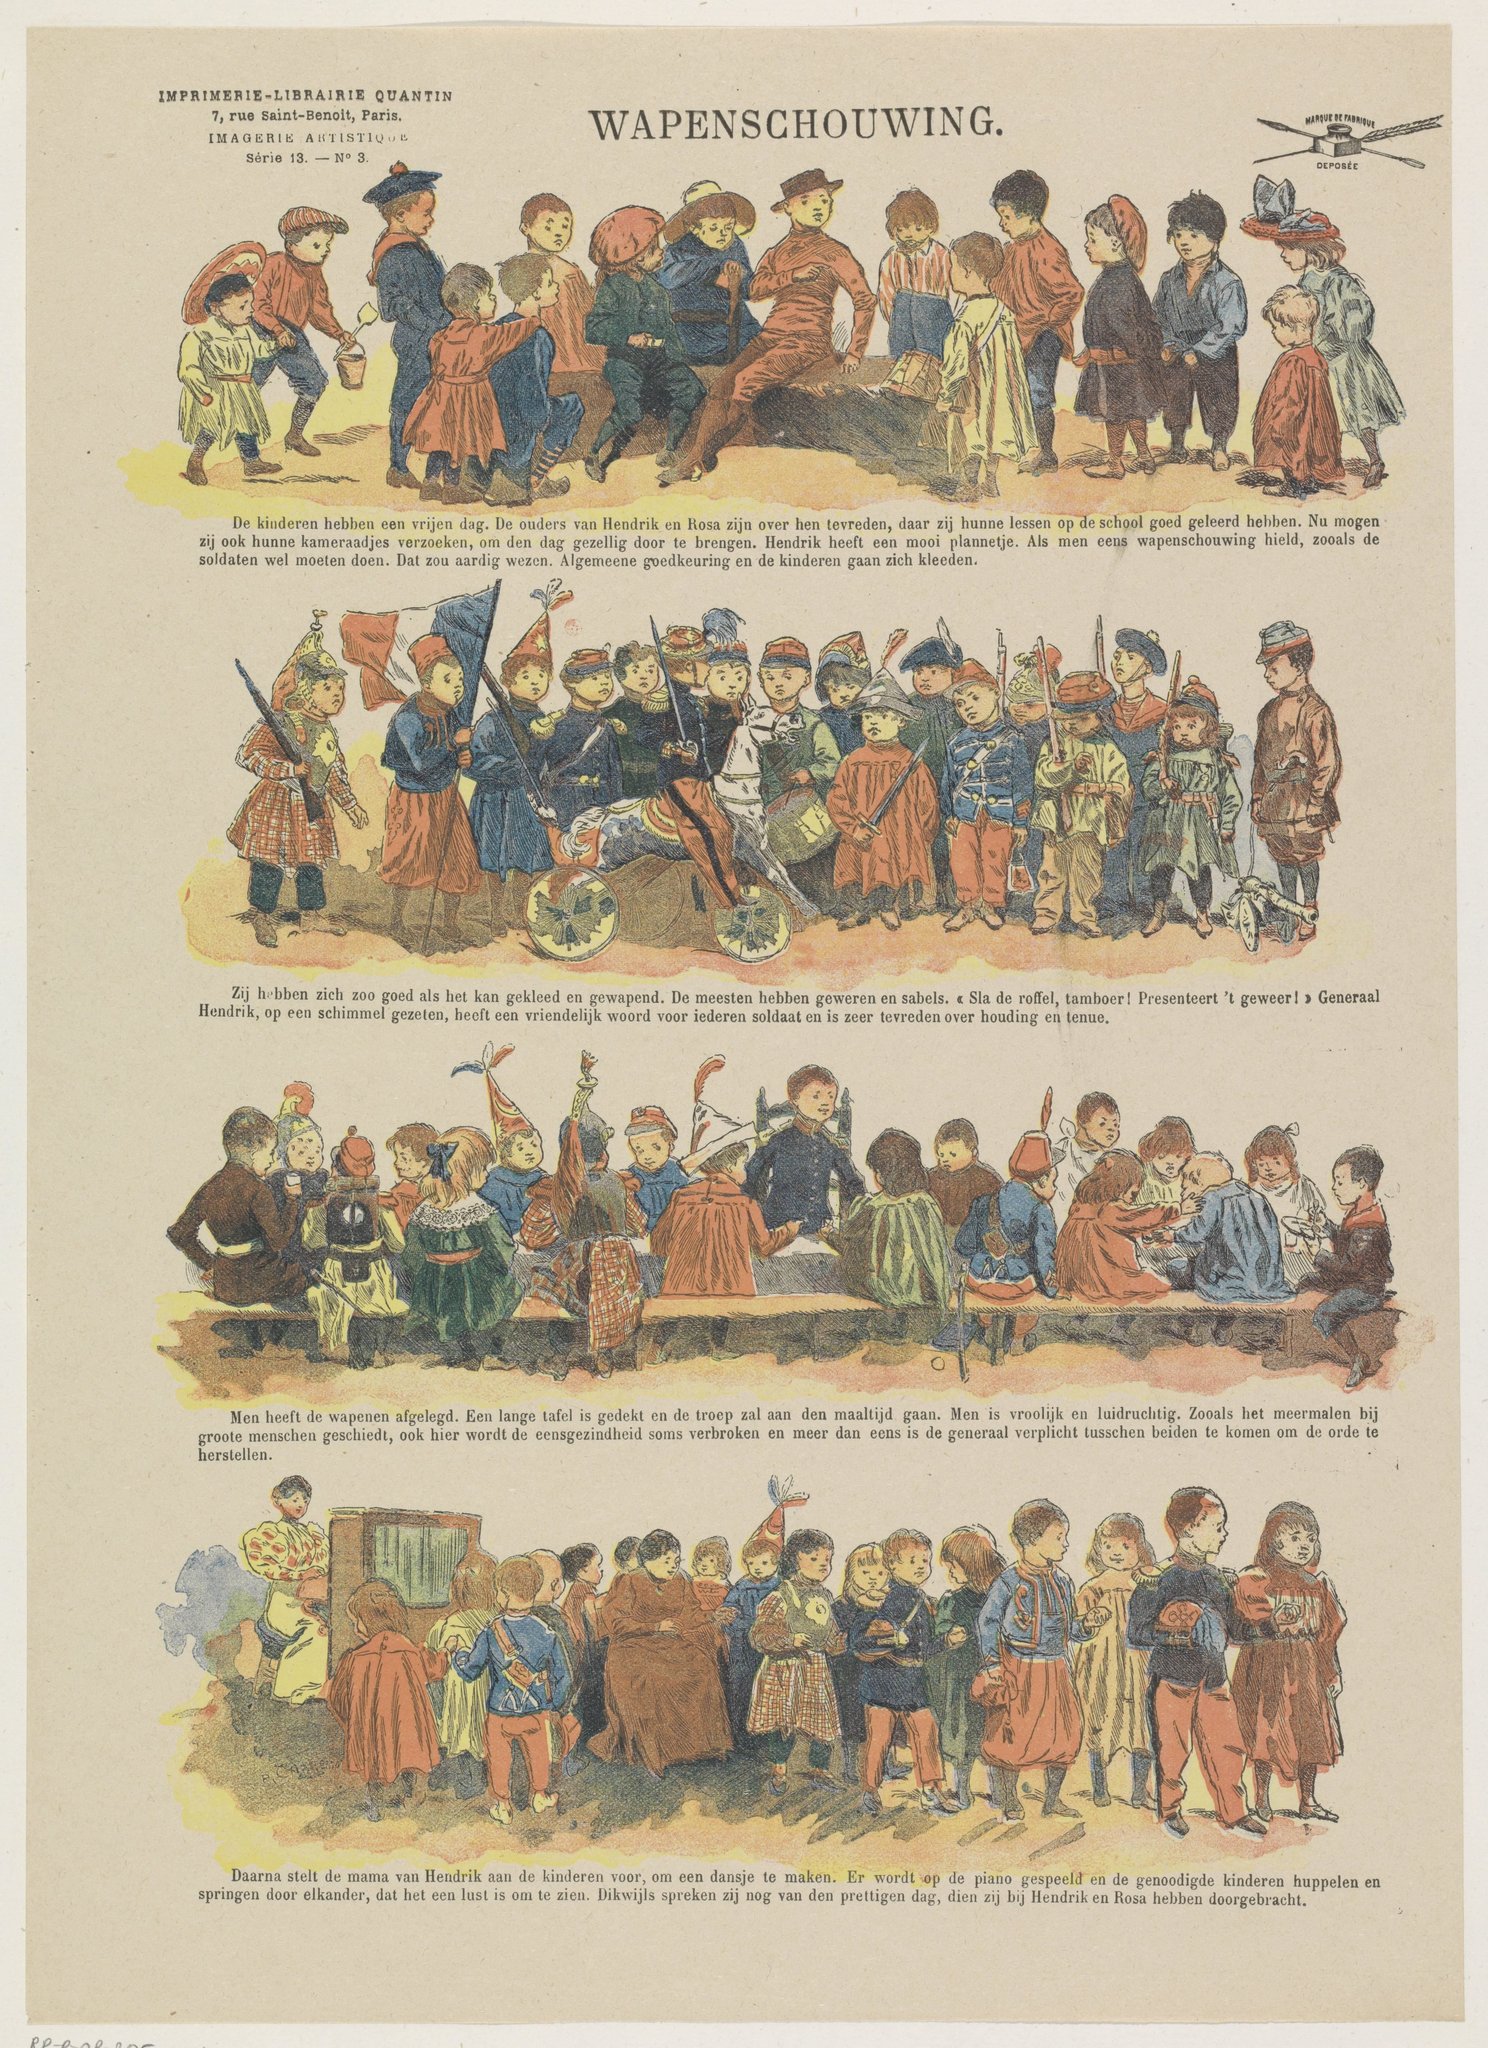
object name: popular print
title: Wapenschouwing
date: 1876-1890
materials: paper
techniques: lithograph, letterpress printing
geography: paris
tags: children's games and plays, tales and fairy tales, the soldier; the soldier's life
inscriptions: : ‘marque de fabrique / deposée’, collector's mark: Lugt 2760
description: Blad met 4 voorstellingen van kinderen die op een vrije dag samen soldaatje spelen. Onder elke afbeelding een onderschrift. Genummerd linksboven: Série 13. - No. 3.